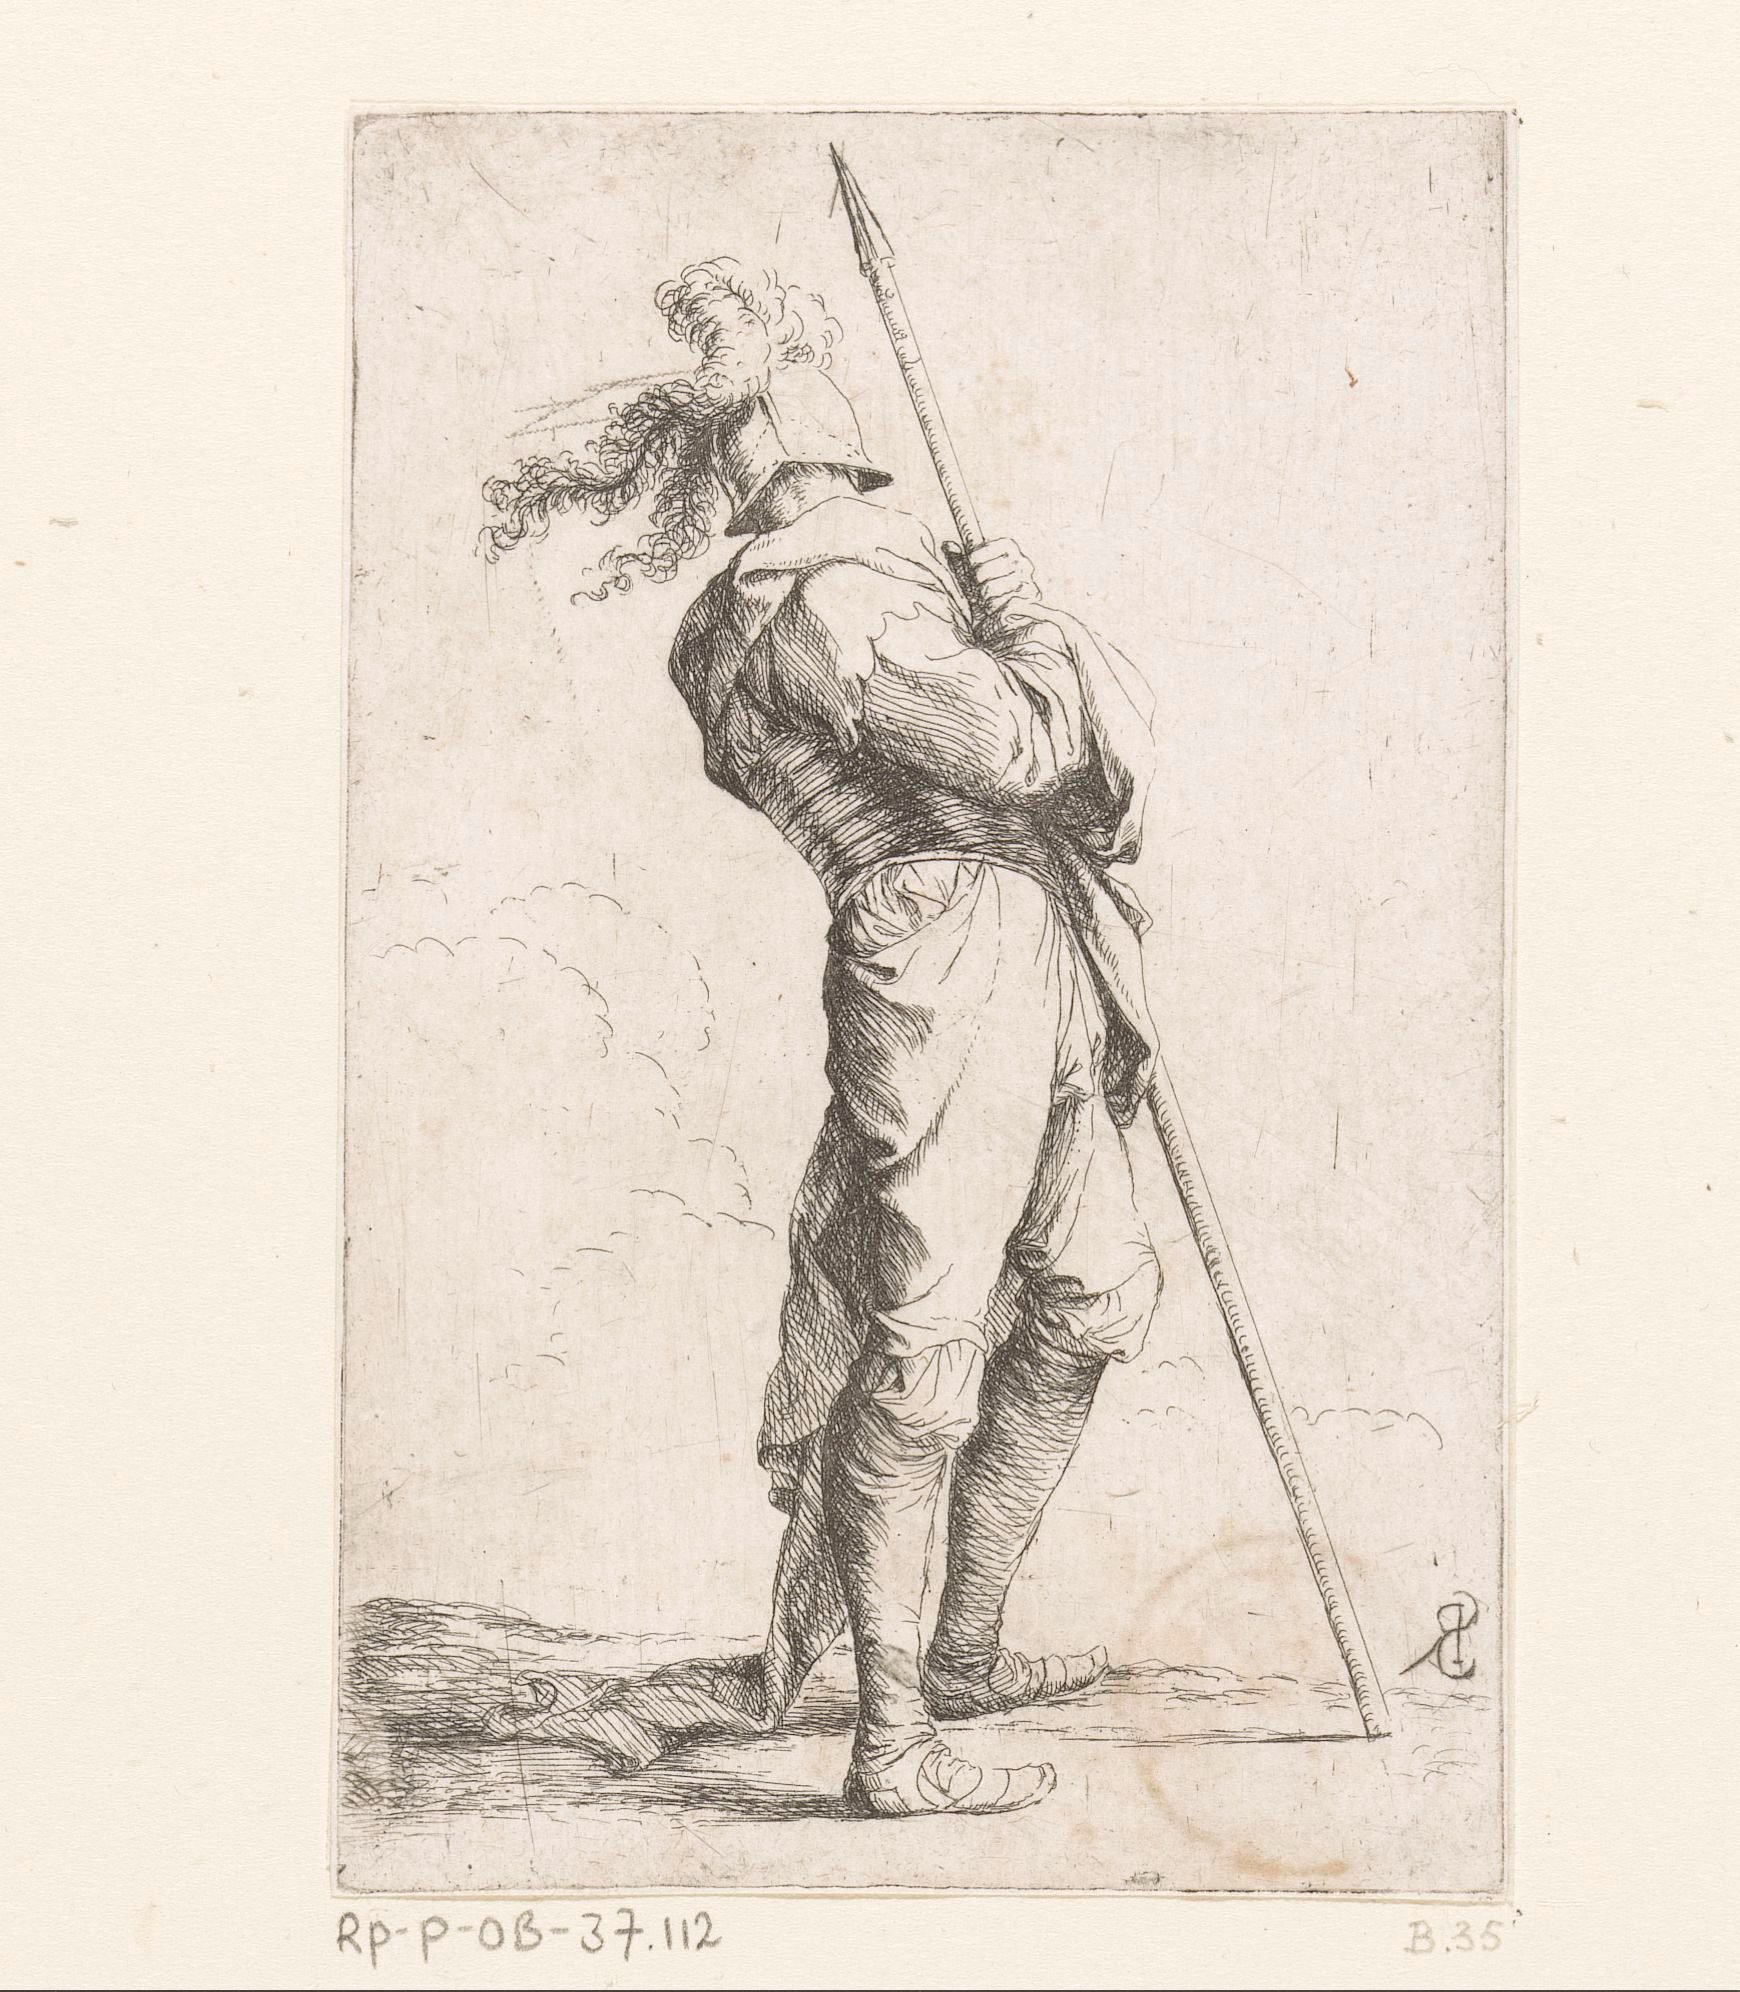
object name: print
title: Soldaat met een lans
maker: salvator rosa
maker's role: draughtsman, painter, print maker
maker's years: 1615-1673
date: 1656-1657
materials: paper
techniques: drypoint, etching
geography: italy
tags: helved weapons, polearms (for striking, hacking, thrusting): lance, the soldier; the soldier's life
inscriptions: collector's mark: Lugt 240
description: Prent spiegelbeeldig naar een tekening die zich eens bevond in de collectie van Ladislao Odescalchi te Rome. De tekening werd in 1976 geveild te Londen. Deze prent maakt deel uit van de serie 'Figurine', bestaande uit een titelprent en 80 prenten van klein formaat met voorstellingen van mannelijke en vrouwelijke figuren. Rosa produceerde de serie waarschijnlijk gedurende de jaren 1656 en 1657.